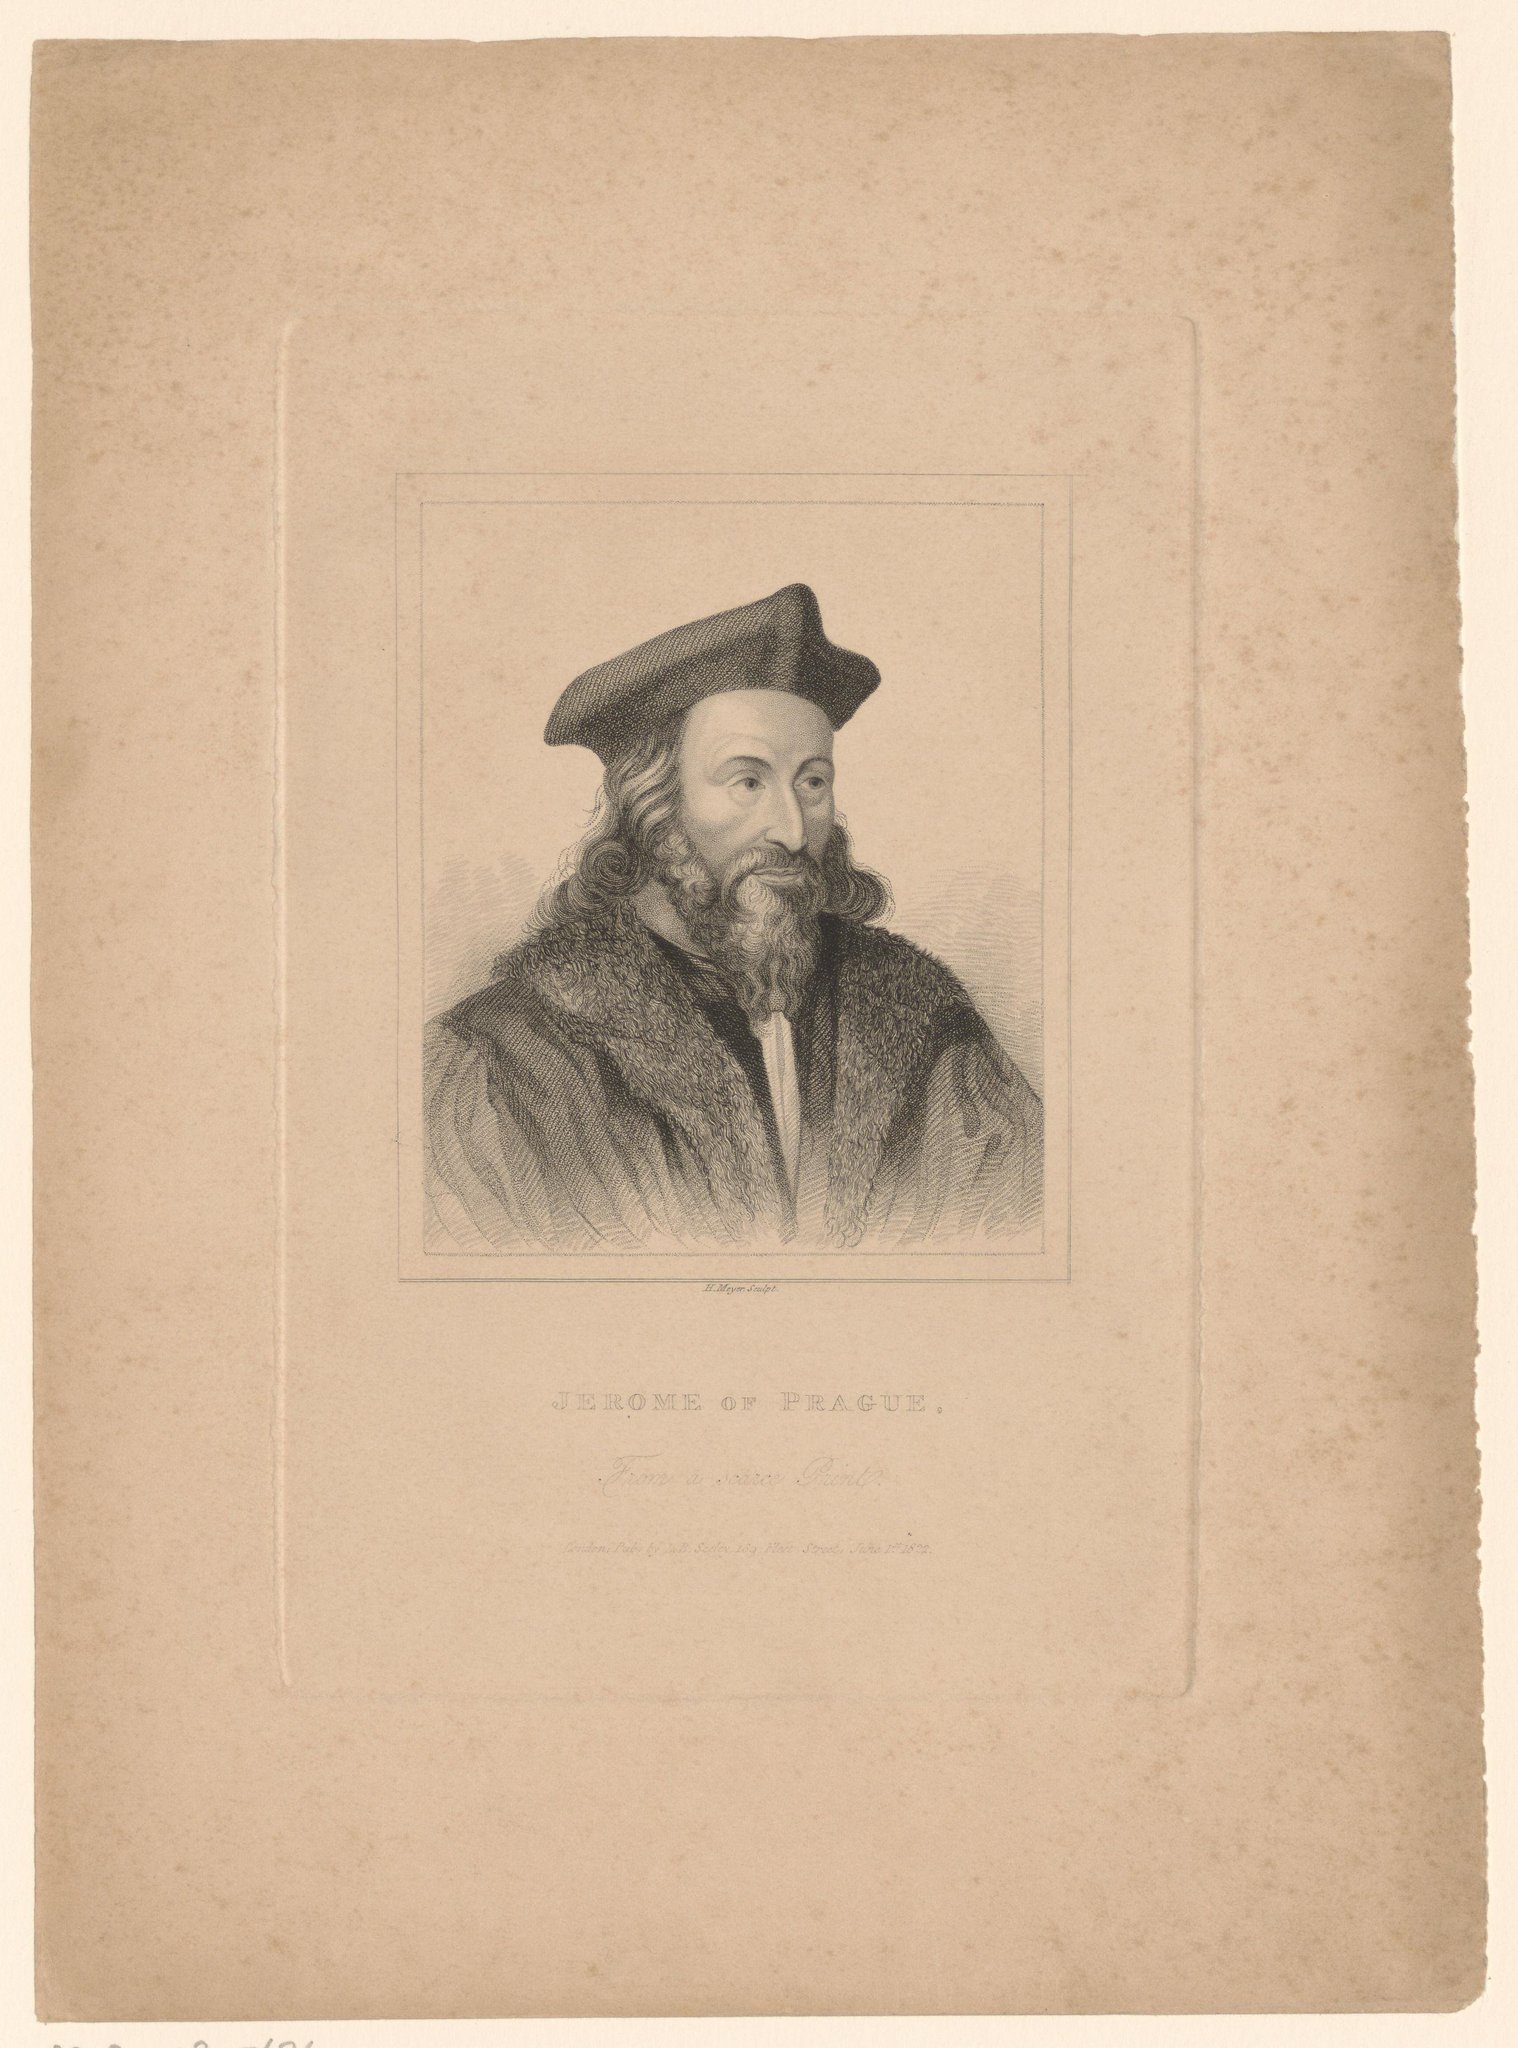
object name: print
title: Jerome of Prague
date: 1806-1822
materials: paper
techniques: etching, roulette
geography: london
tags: theologian, historical persons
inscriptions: collector's mark: Lugt 2228